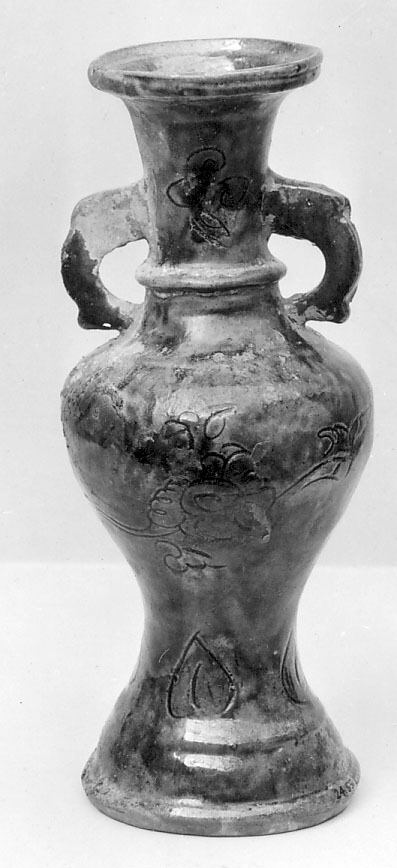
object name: vase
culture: chinese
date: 1368-1644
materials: pottery